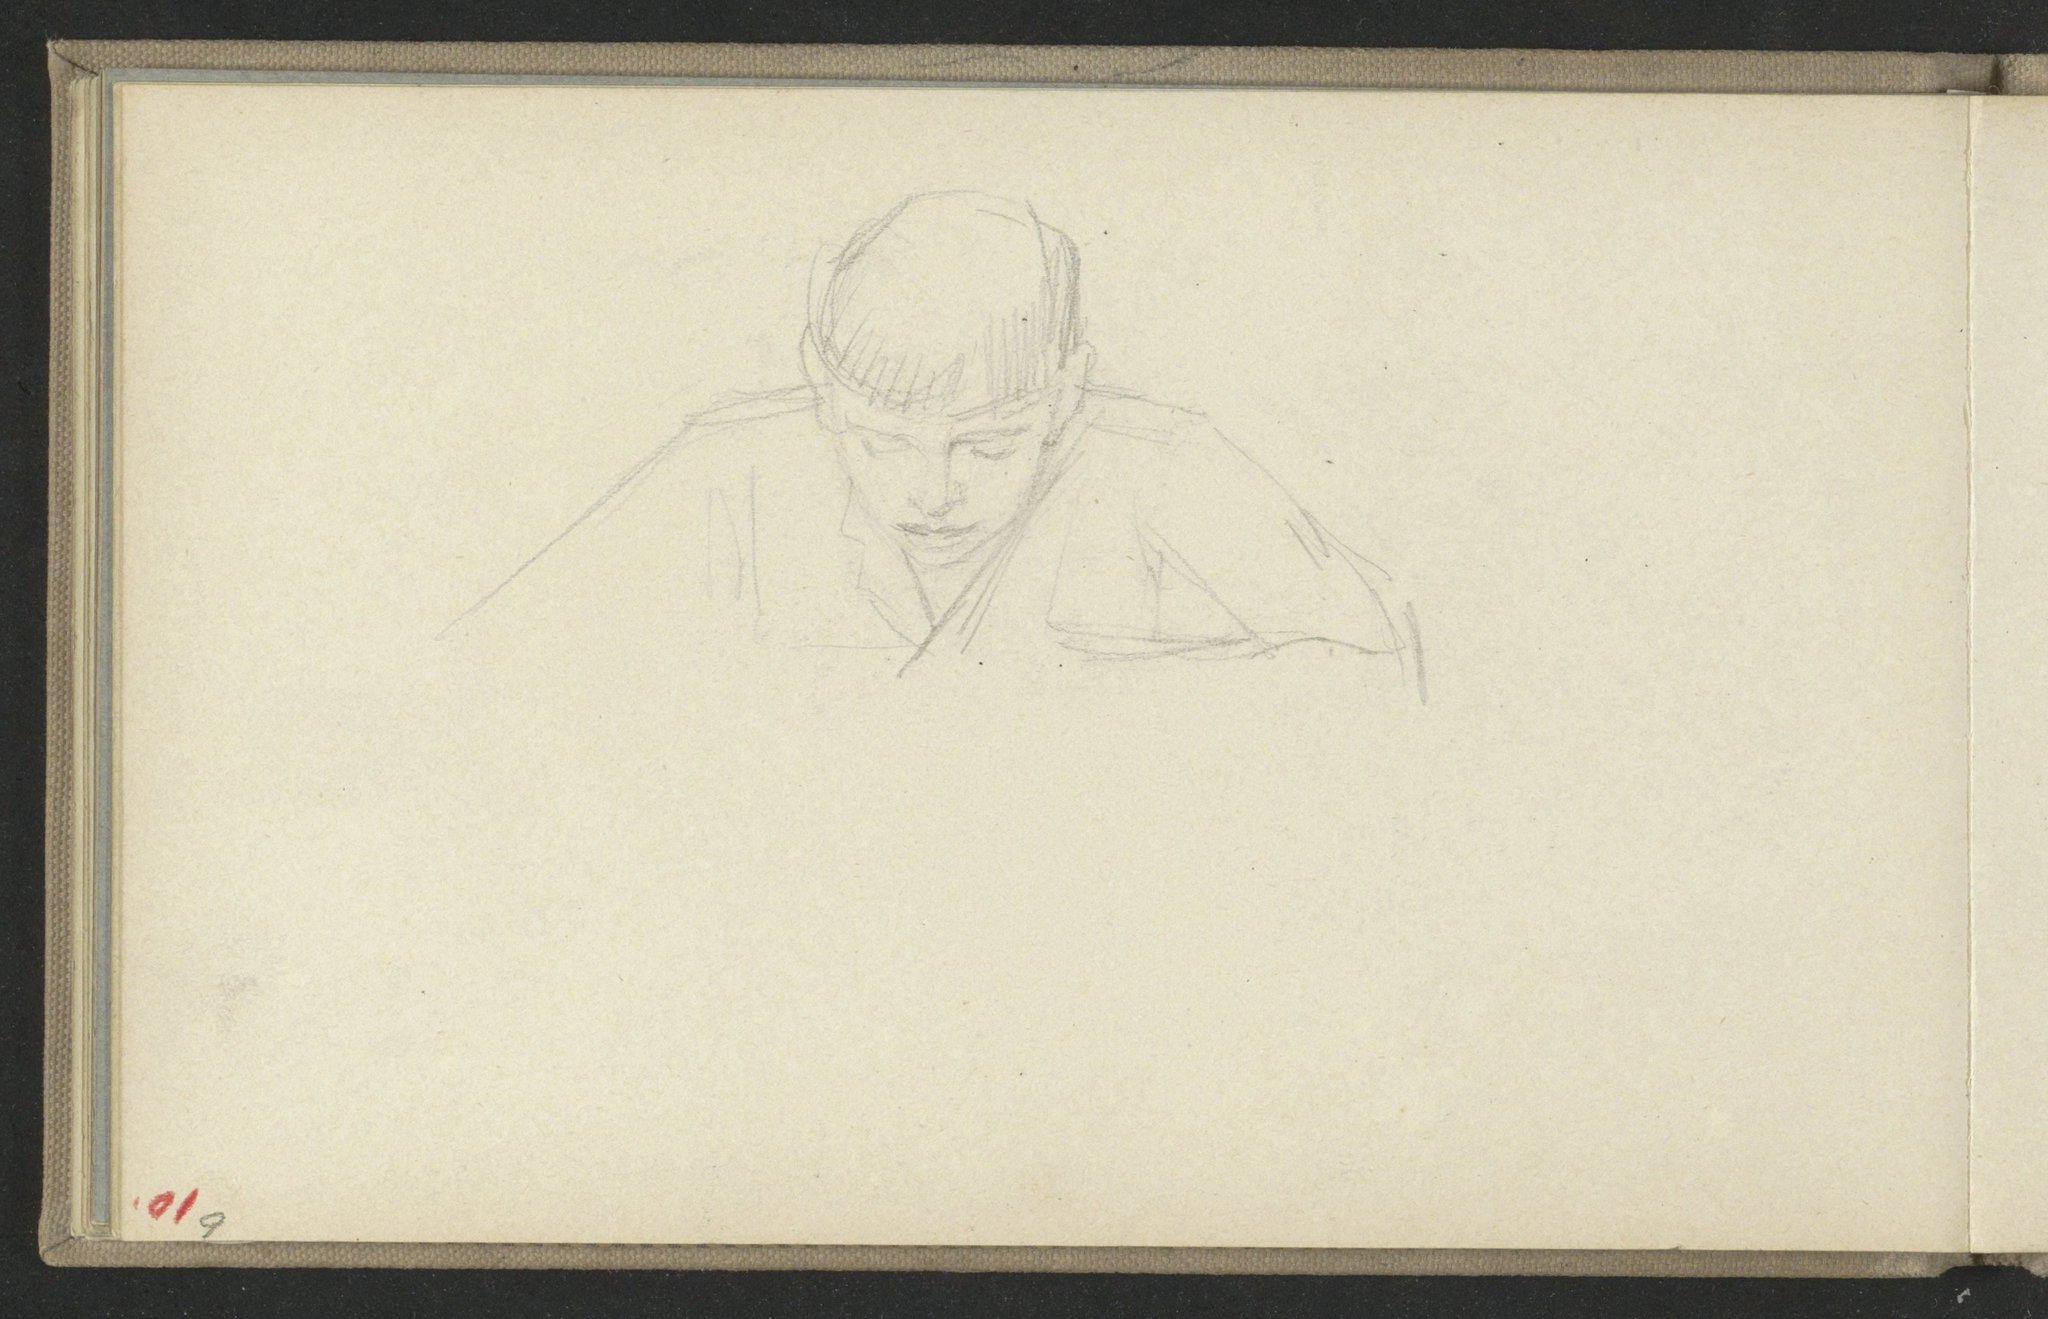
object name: sketchbook leaf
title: Voorovergebogen jongen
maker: jozef israëls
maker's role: draughtsman, painter, print maker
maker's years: 1824-1911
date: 1834-1911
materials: paper, pencil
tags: head bent forward; bowing - aa - female human figure (+ young male (human being))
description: Blad 20 verso uit een schetsboek met 26 bladen.